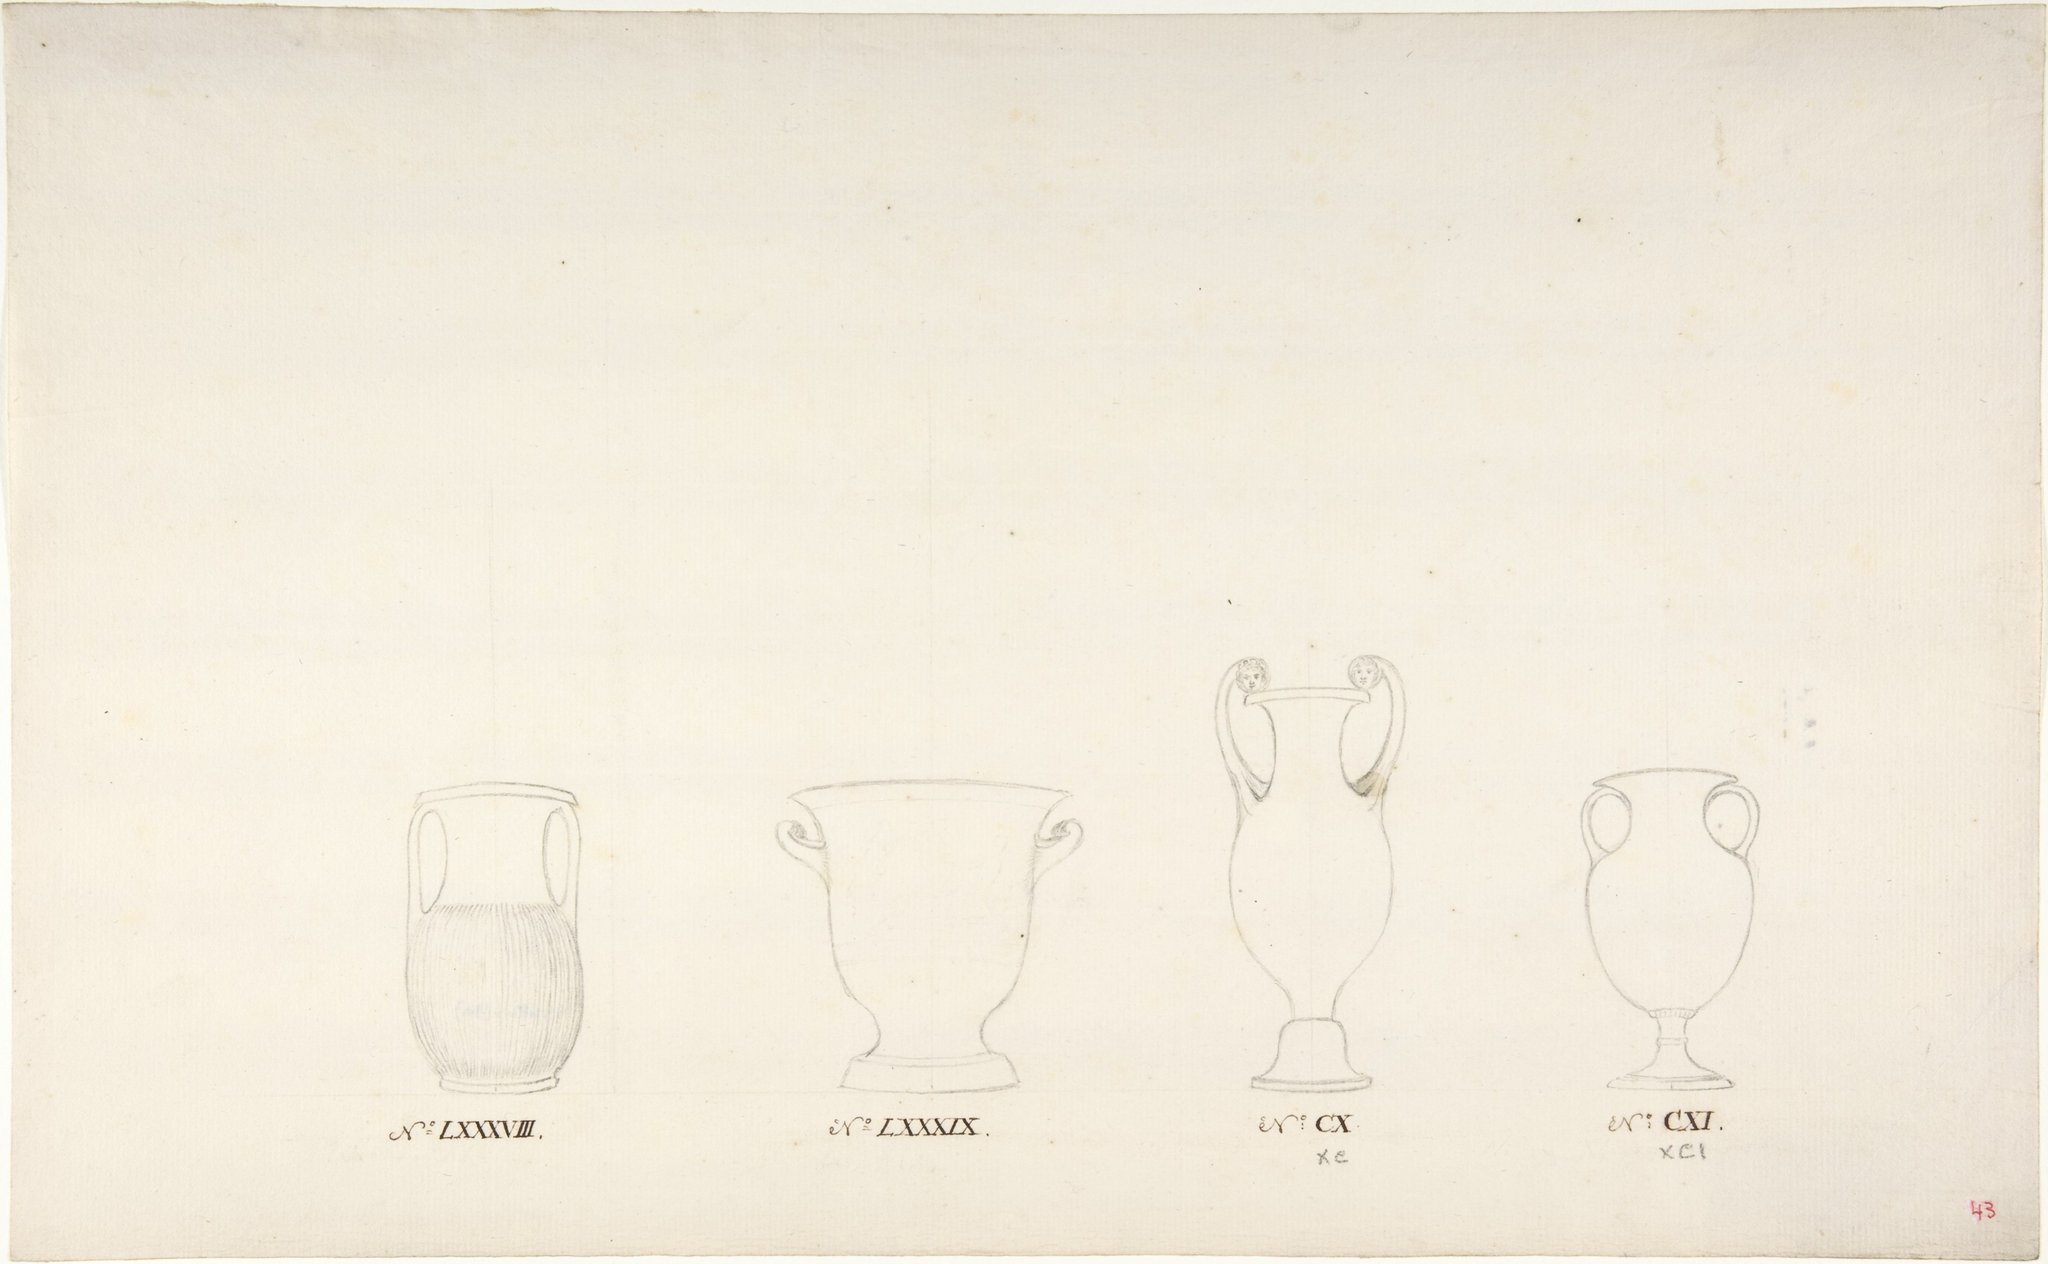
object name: drawing ornament architecture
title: Design for Four Vases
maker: anonymous, french, 18th century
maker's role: artist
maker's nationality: french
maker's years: 1700-1800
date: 1770-1785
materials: chalk, ink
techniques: pen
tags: vases